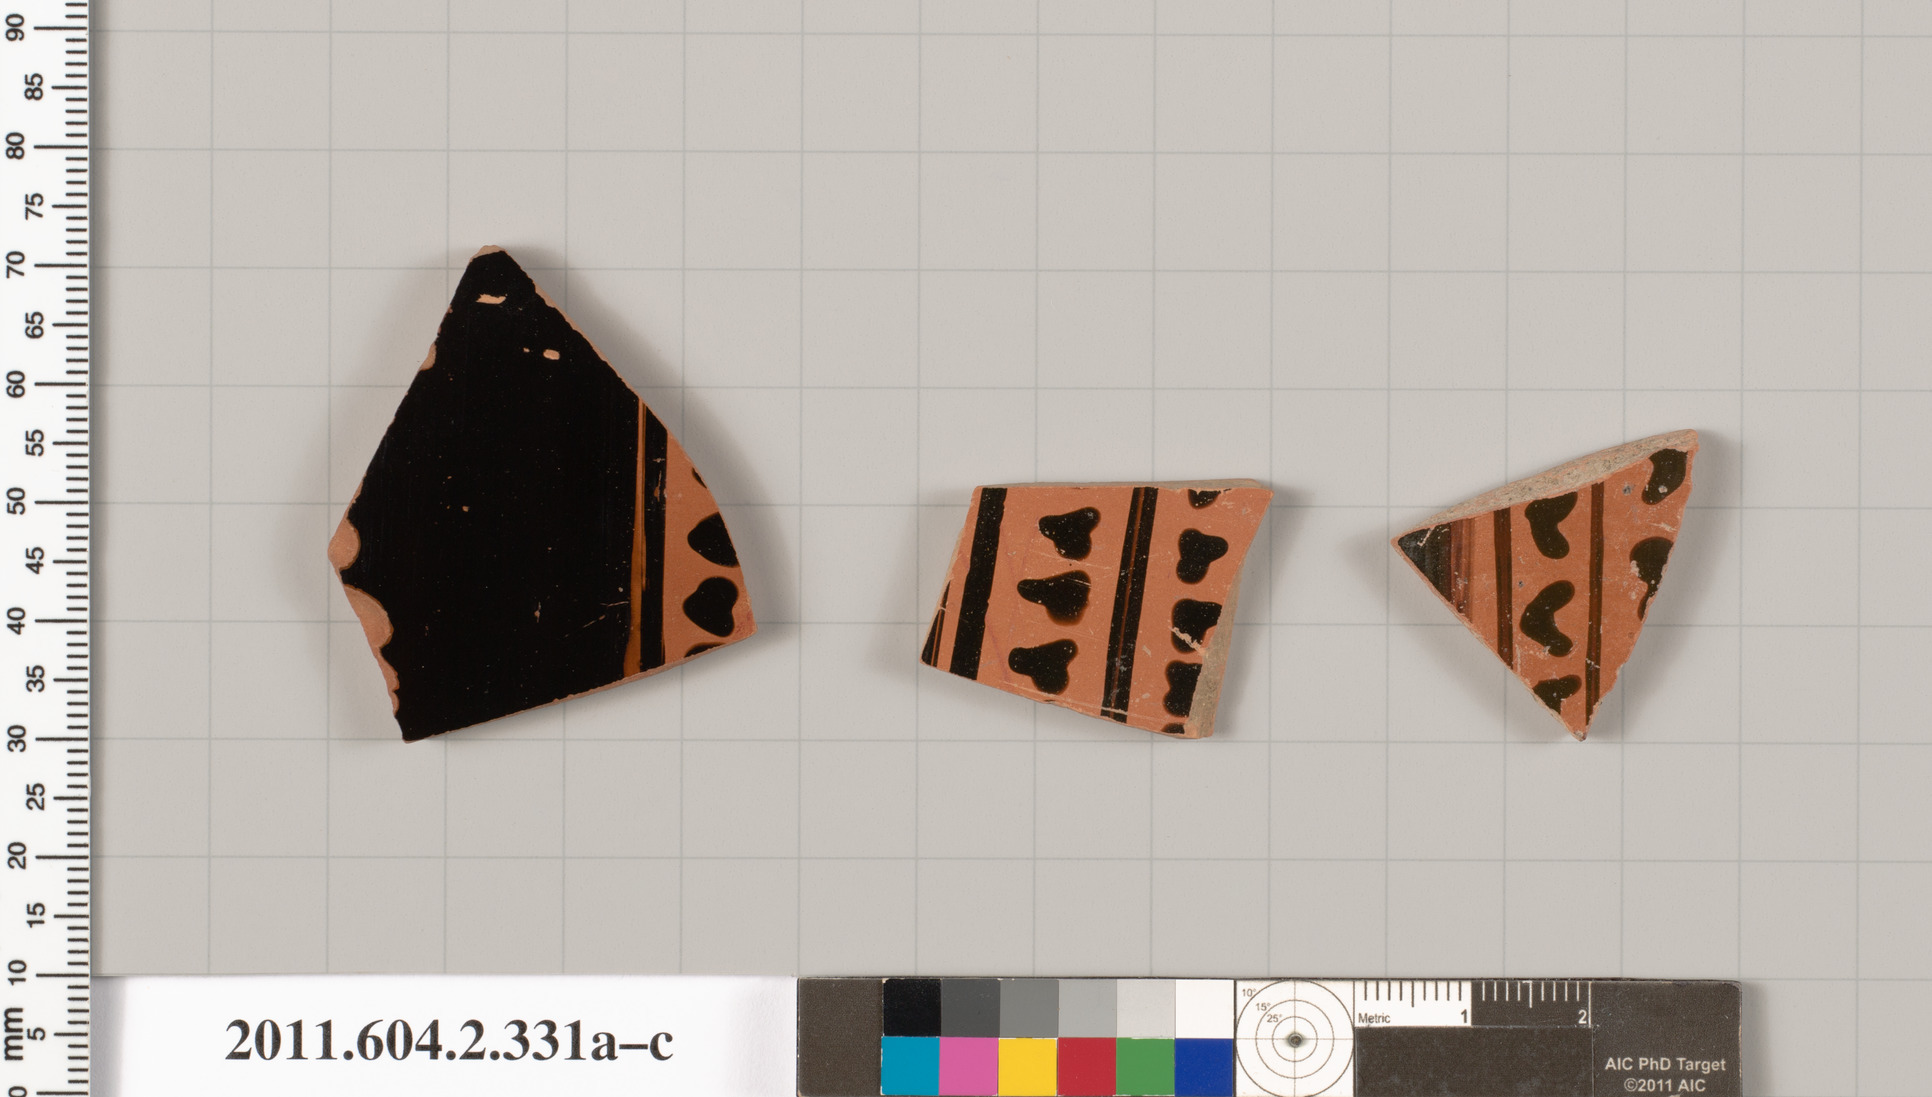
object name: column krater fragment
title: Terracotta fragments of column-kraters (bowls for mixing wine and water)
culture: greek, attic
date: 460-440 BCE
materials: terracotta